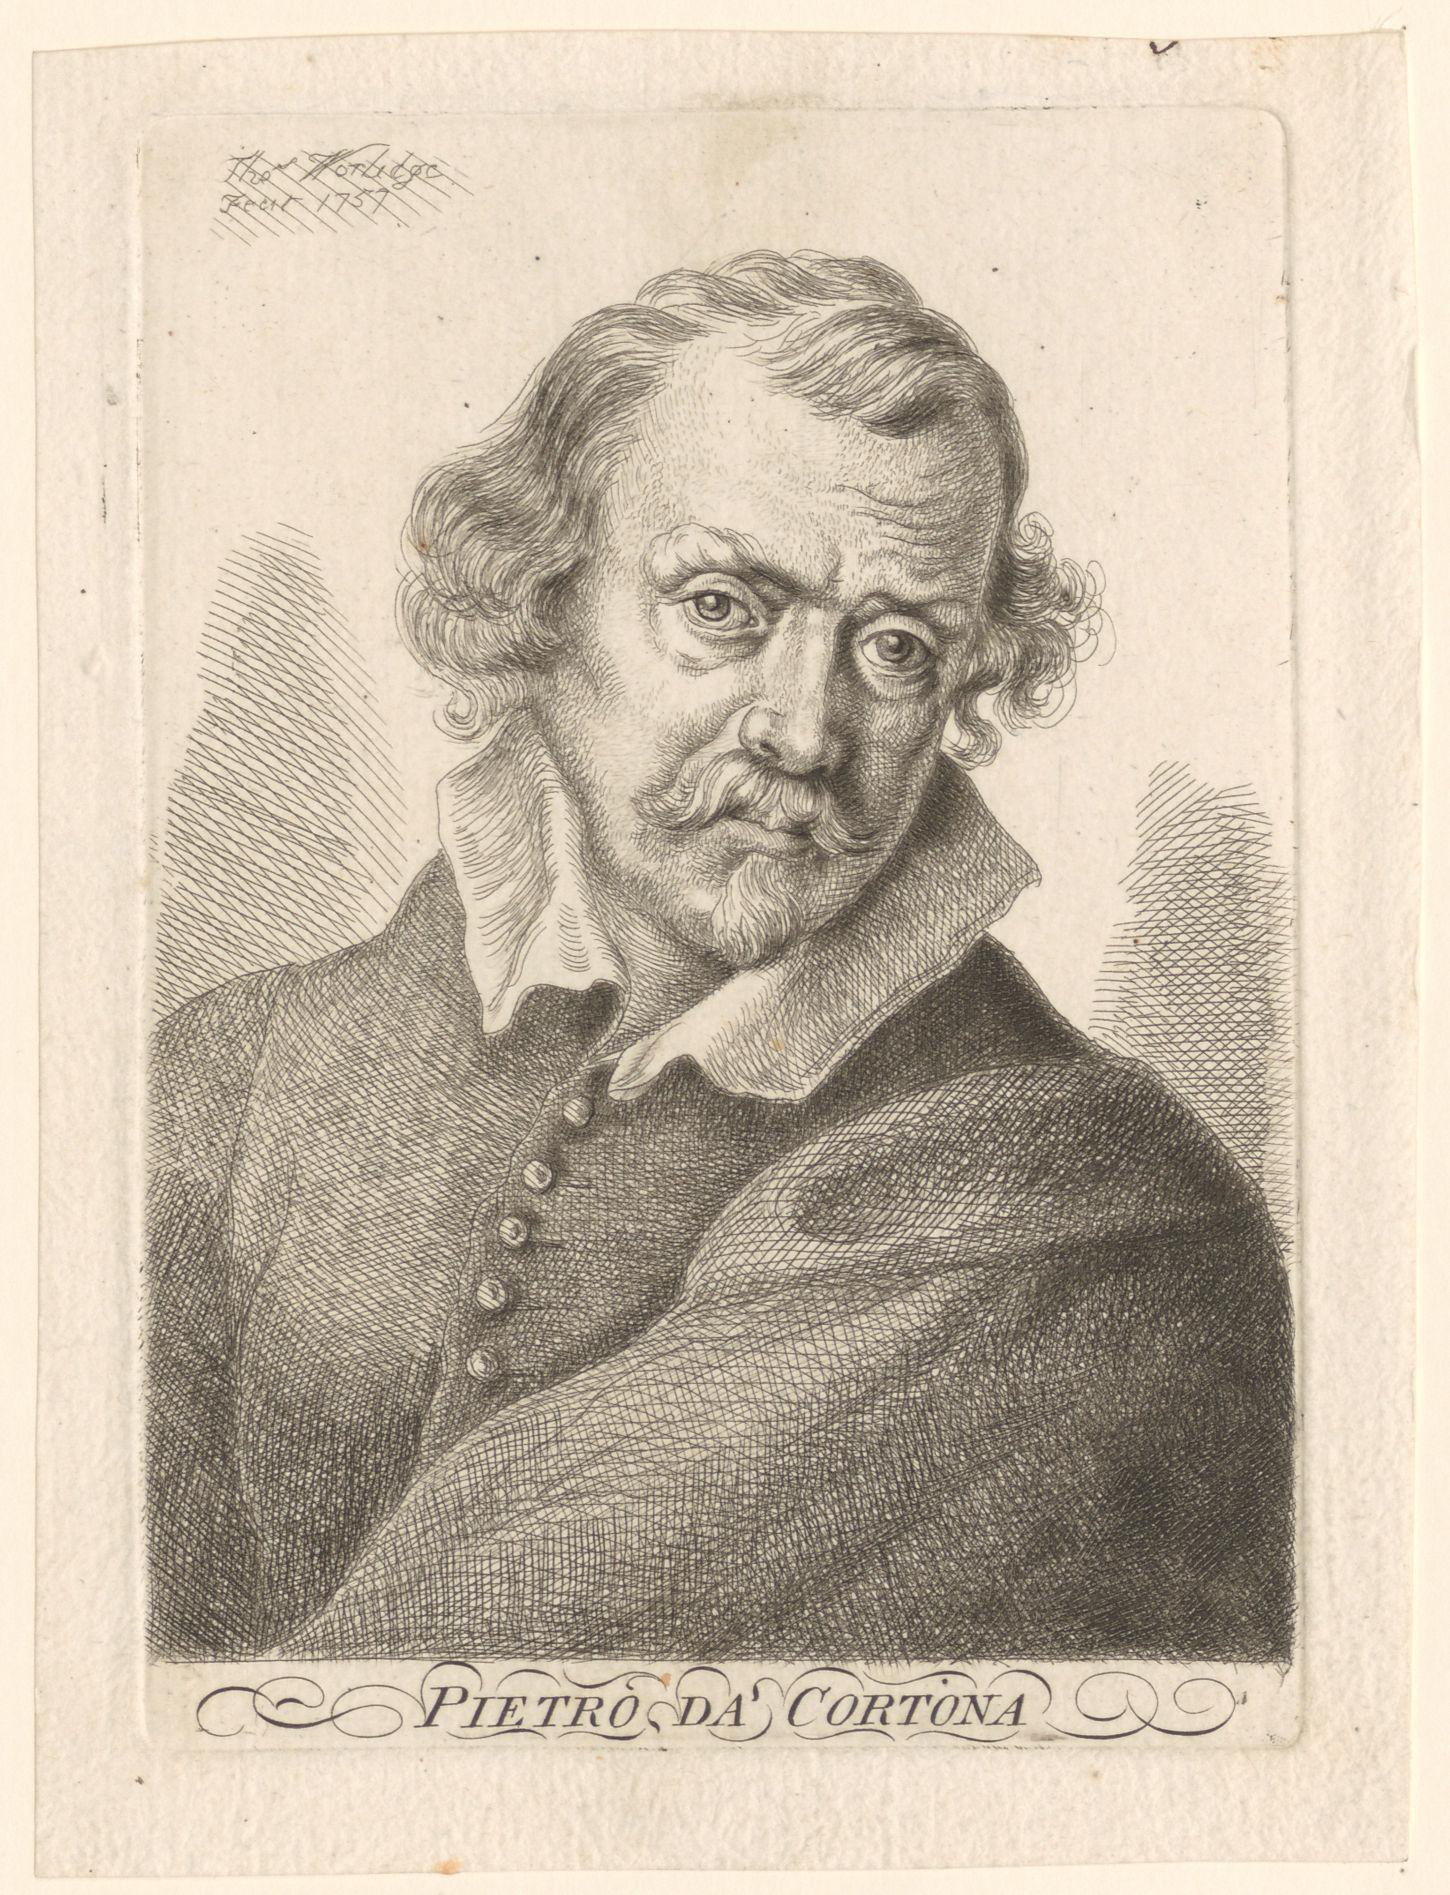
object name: print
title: Portret van Pietro da Cortona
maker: thomas worlidge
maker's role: print maker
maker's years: 1700-1766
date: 1757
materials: paper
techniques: etching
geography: london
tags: rome, painter, draughtsman, designer, pietro da cortona, historical persons, portrait, self-portrait of artist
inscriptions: collector's mark: Lugt 2760, collector's mark: Lugt 2228